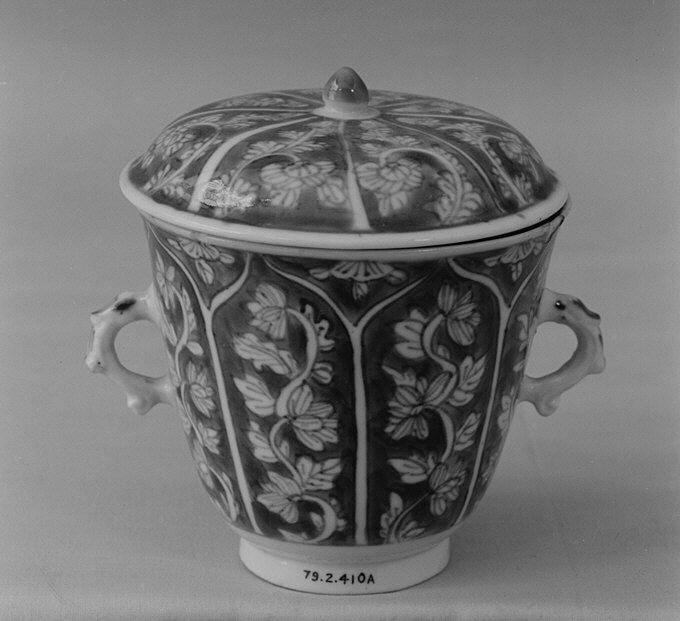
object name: cup with cover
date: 1700-1720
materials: hard paste porcelain